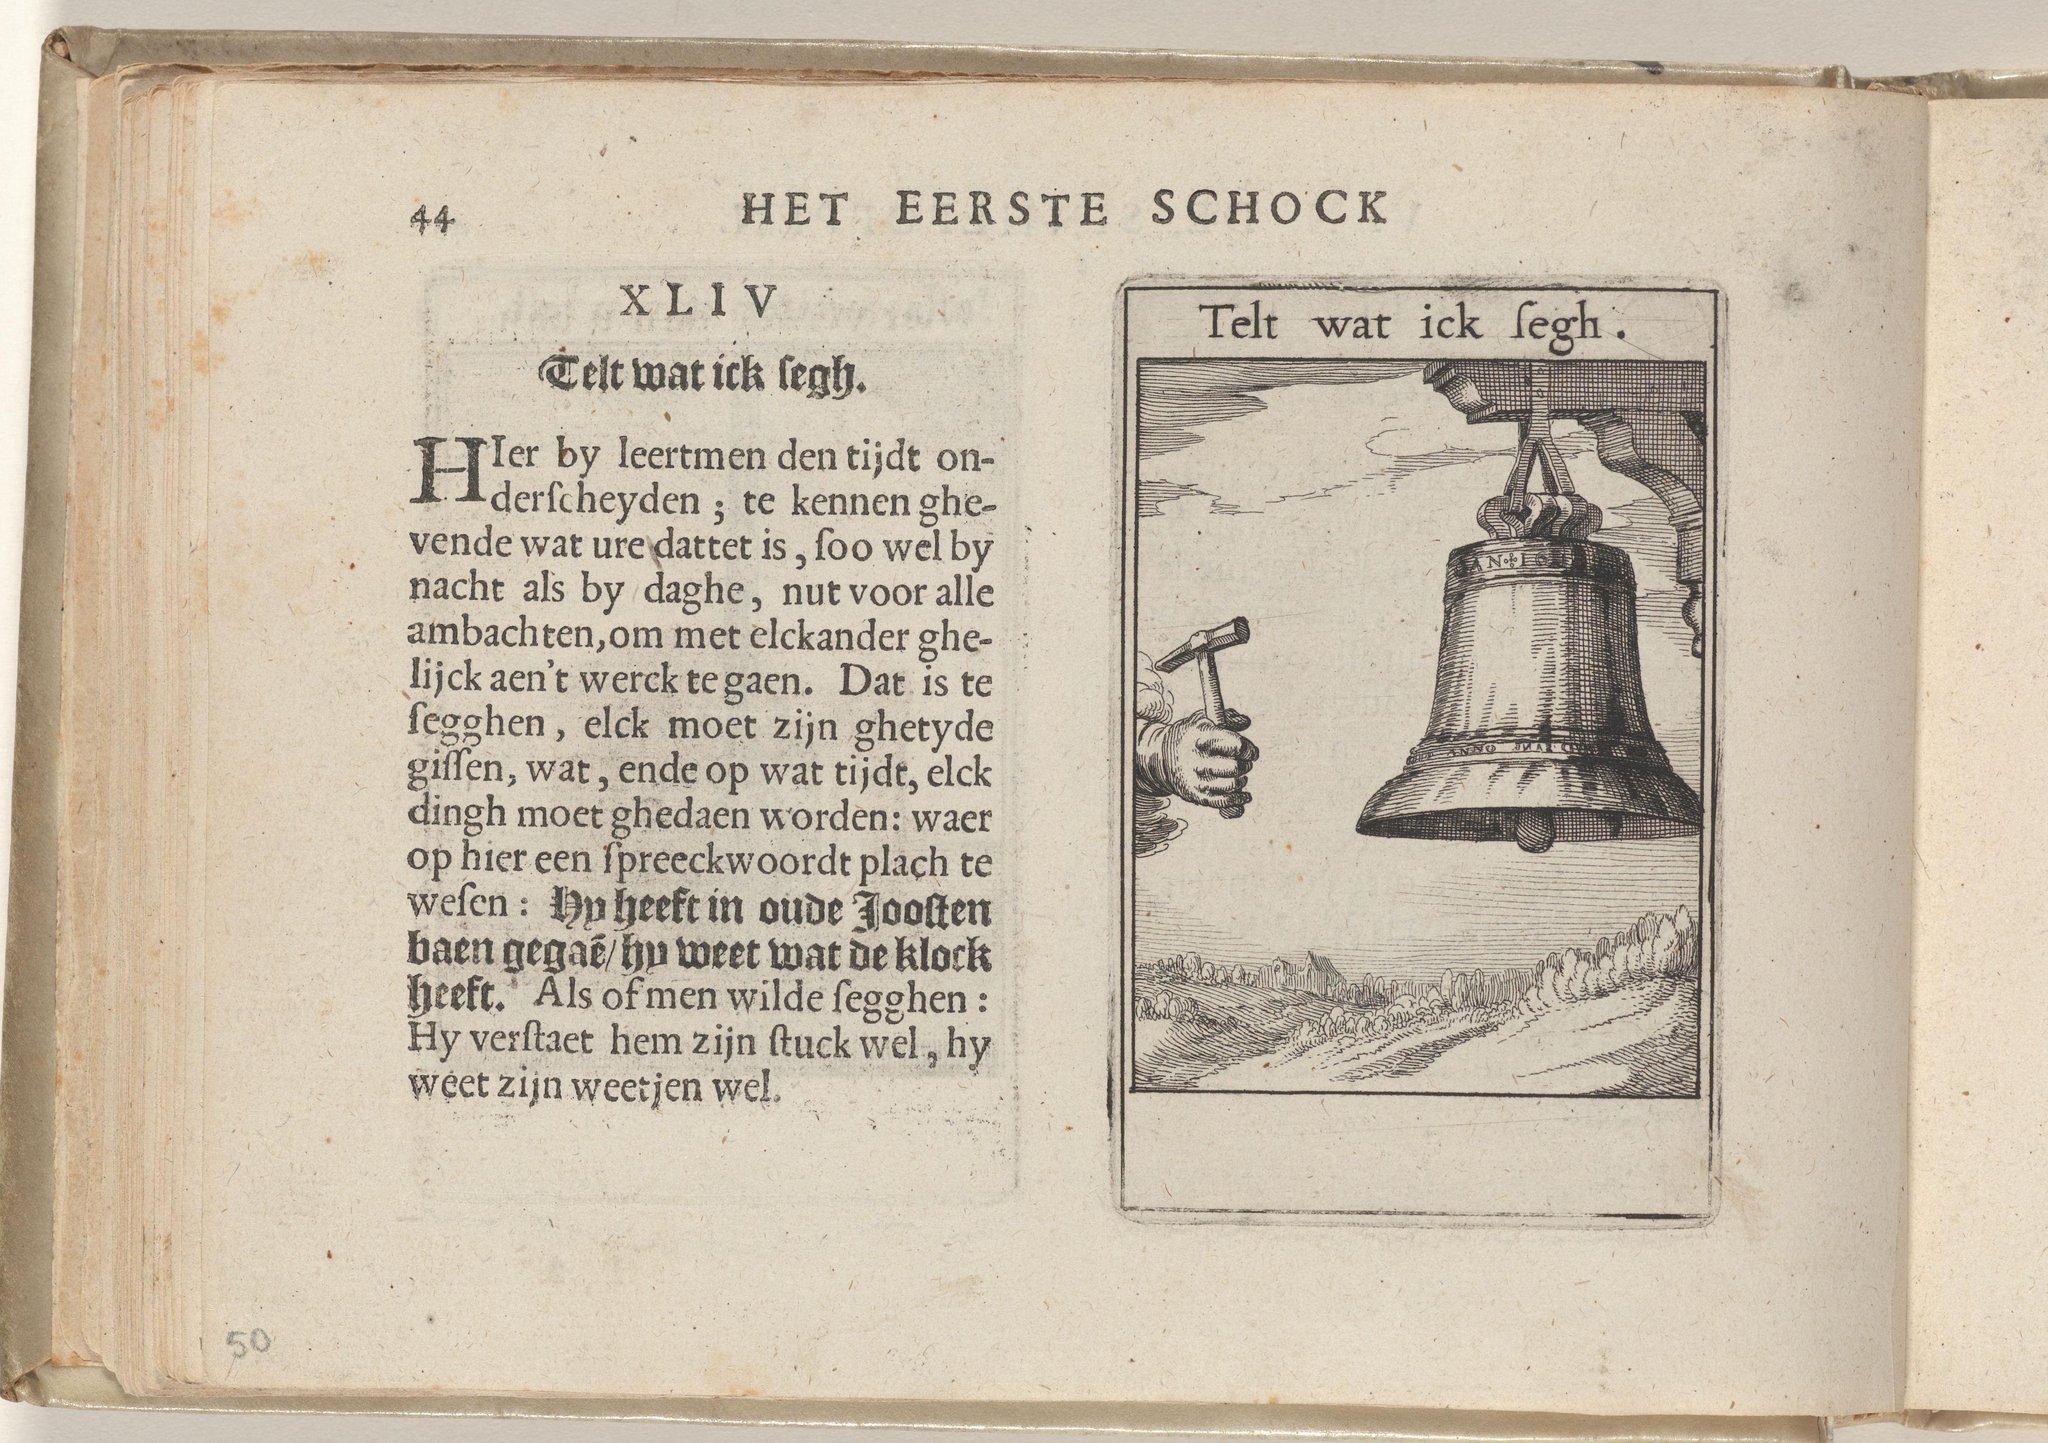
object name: print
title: XLIV Telt wat ick segh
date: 1614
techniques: engraving, printing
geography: amsterdam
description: XLIV Telt wat ick segh. Eerste schok. Onderdeel van 'Sinnepoppen', R. Visscher, 1614.